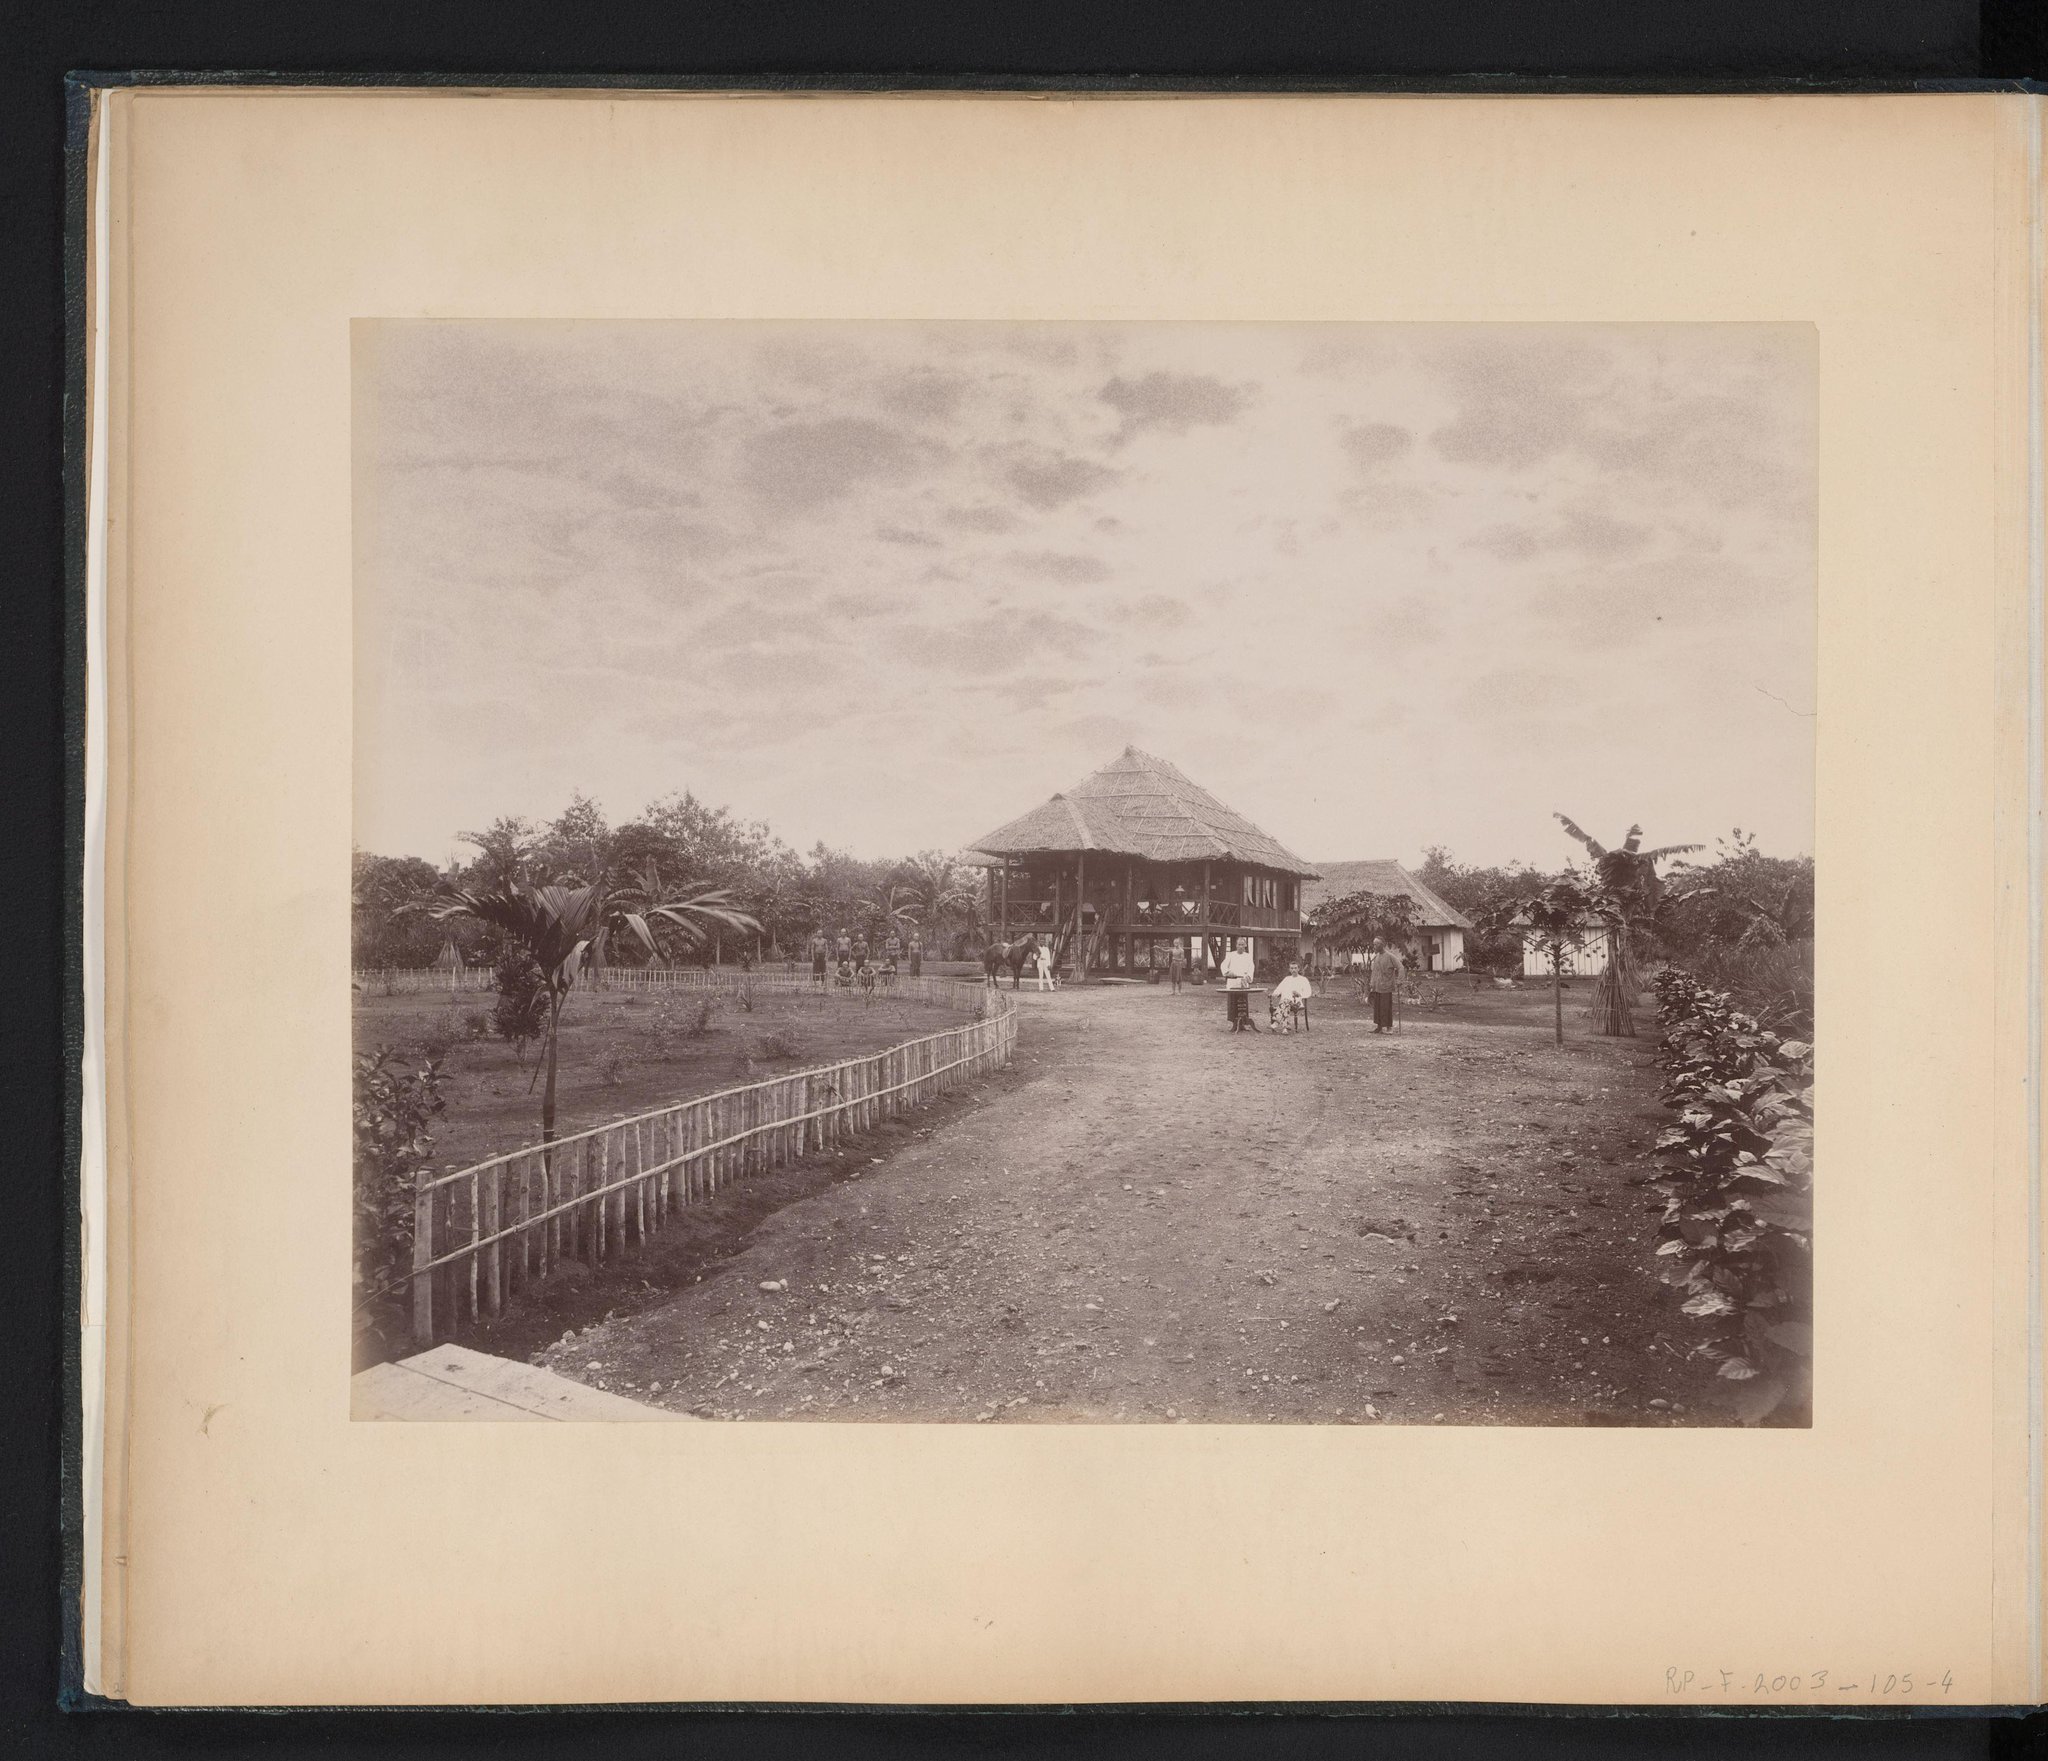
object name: photograph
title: Gezicht op huis van Europese man met bedienden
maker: Anonymous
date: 1890-1900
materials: cardboard, photographic support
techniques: albumen print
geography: sumatra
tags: plantation, director, boss (in modern industry), rural housing, e.g. country-house, villa, cottage, house personnel, servants, sumatra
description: Gezicht op plantage met verschillende gebouwen en op de voorgrond Europese man en bedienden. Deze foto is vermoedelijk gemaakt in Langkat, Sumatra. Deze foto maakt deel uit van een album.